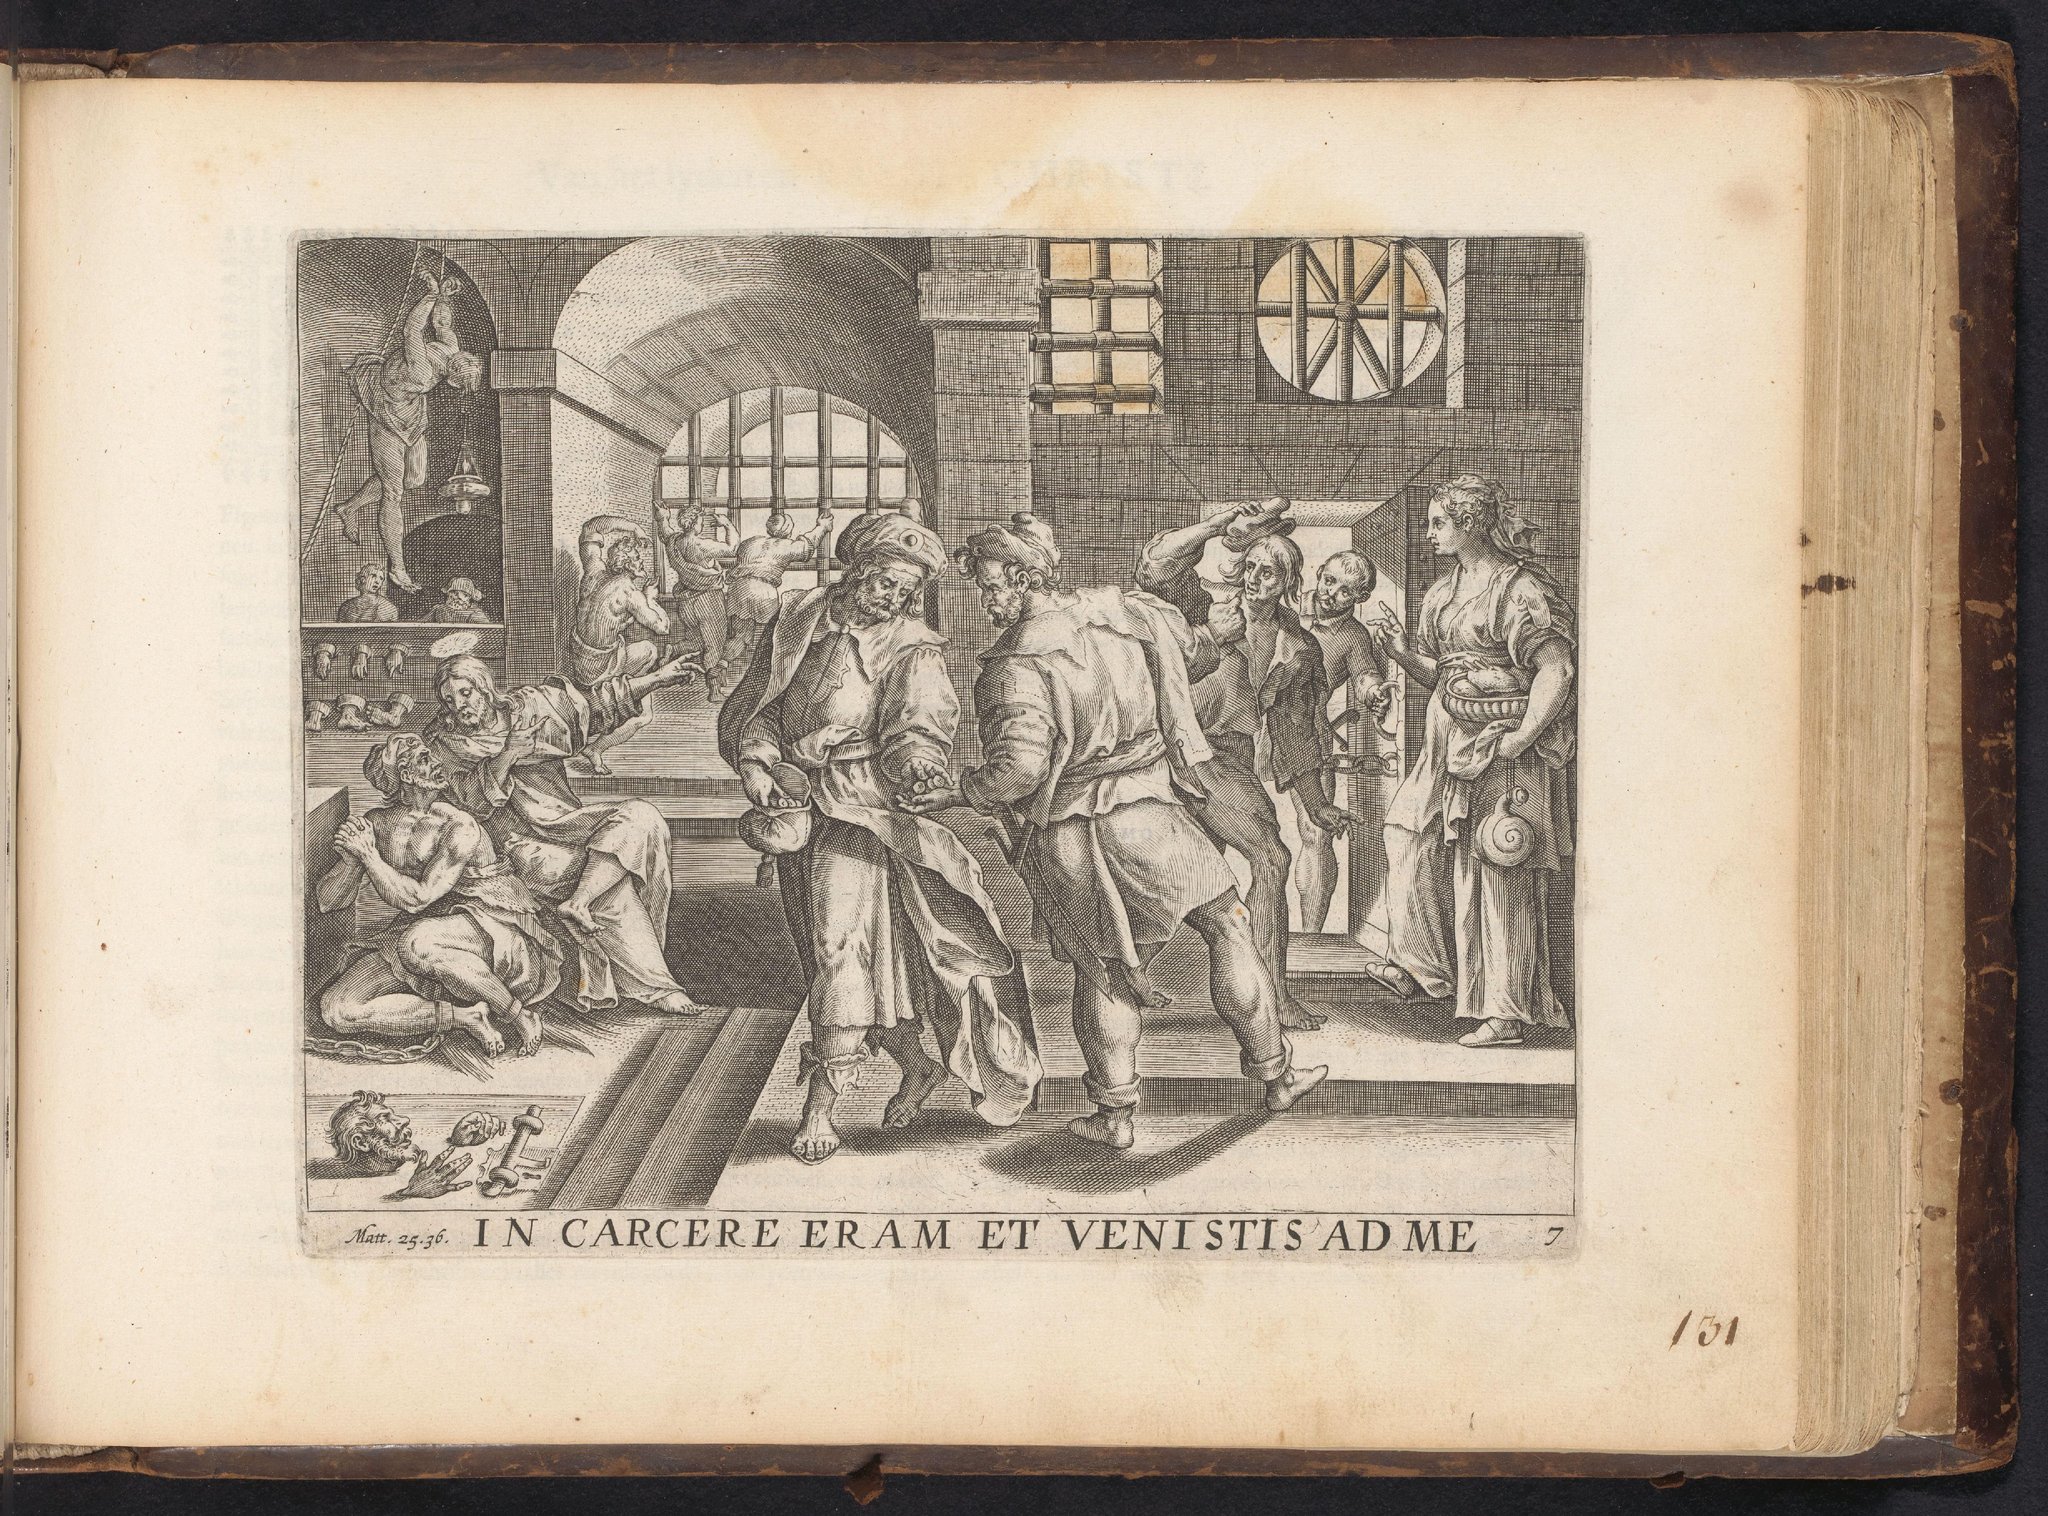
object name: print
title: Zeven werken van barmhartigheid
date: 1585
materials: paper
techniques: engraving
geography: amsterdam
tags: visiting or liberating the imprisoned, 'incarceratus solatur' ~ one of the (seven) acts of mercy - vv - christ present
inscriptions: number: ‘131’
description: Verschillende mensen bezoeken de gevangenen in de gevangenis. Een man koopt een gevangene vrij. Een vrouw brengt voedsel. Christus spreekt links met een gevangene en wijst hem op de deur. Onder de voorstelling een verwijzing in het Latijn naar de Bijbeltekst in Mat. 25:36. Deze prent maakt deel uit van een album.